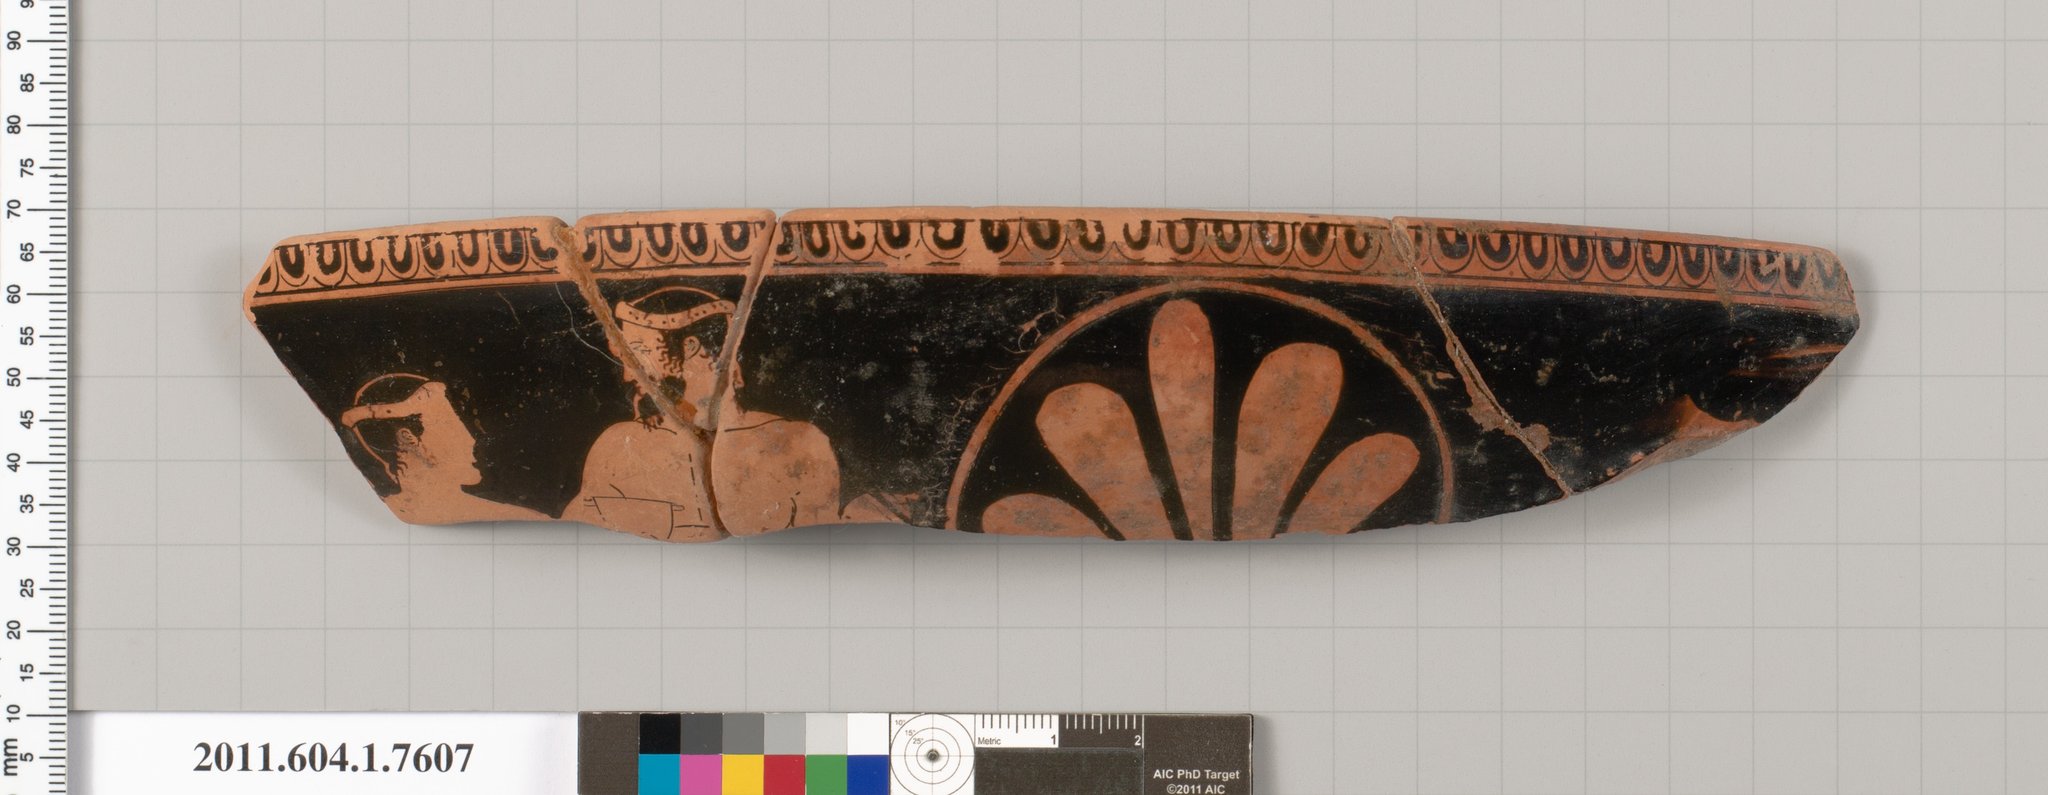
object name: kylix fragment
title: Terracotta fragment of a kylix (drinking cup)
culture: greek, attic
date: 460-450 BCE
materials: terracotta